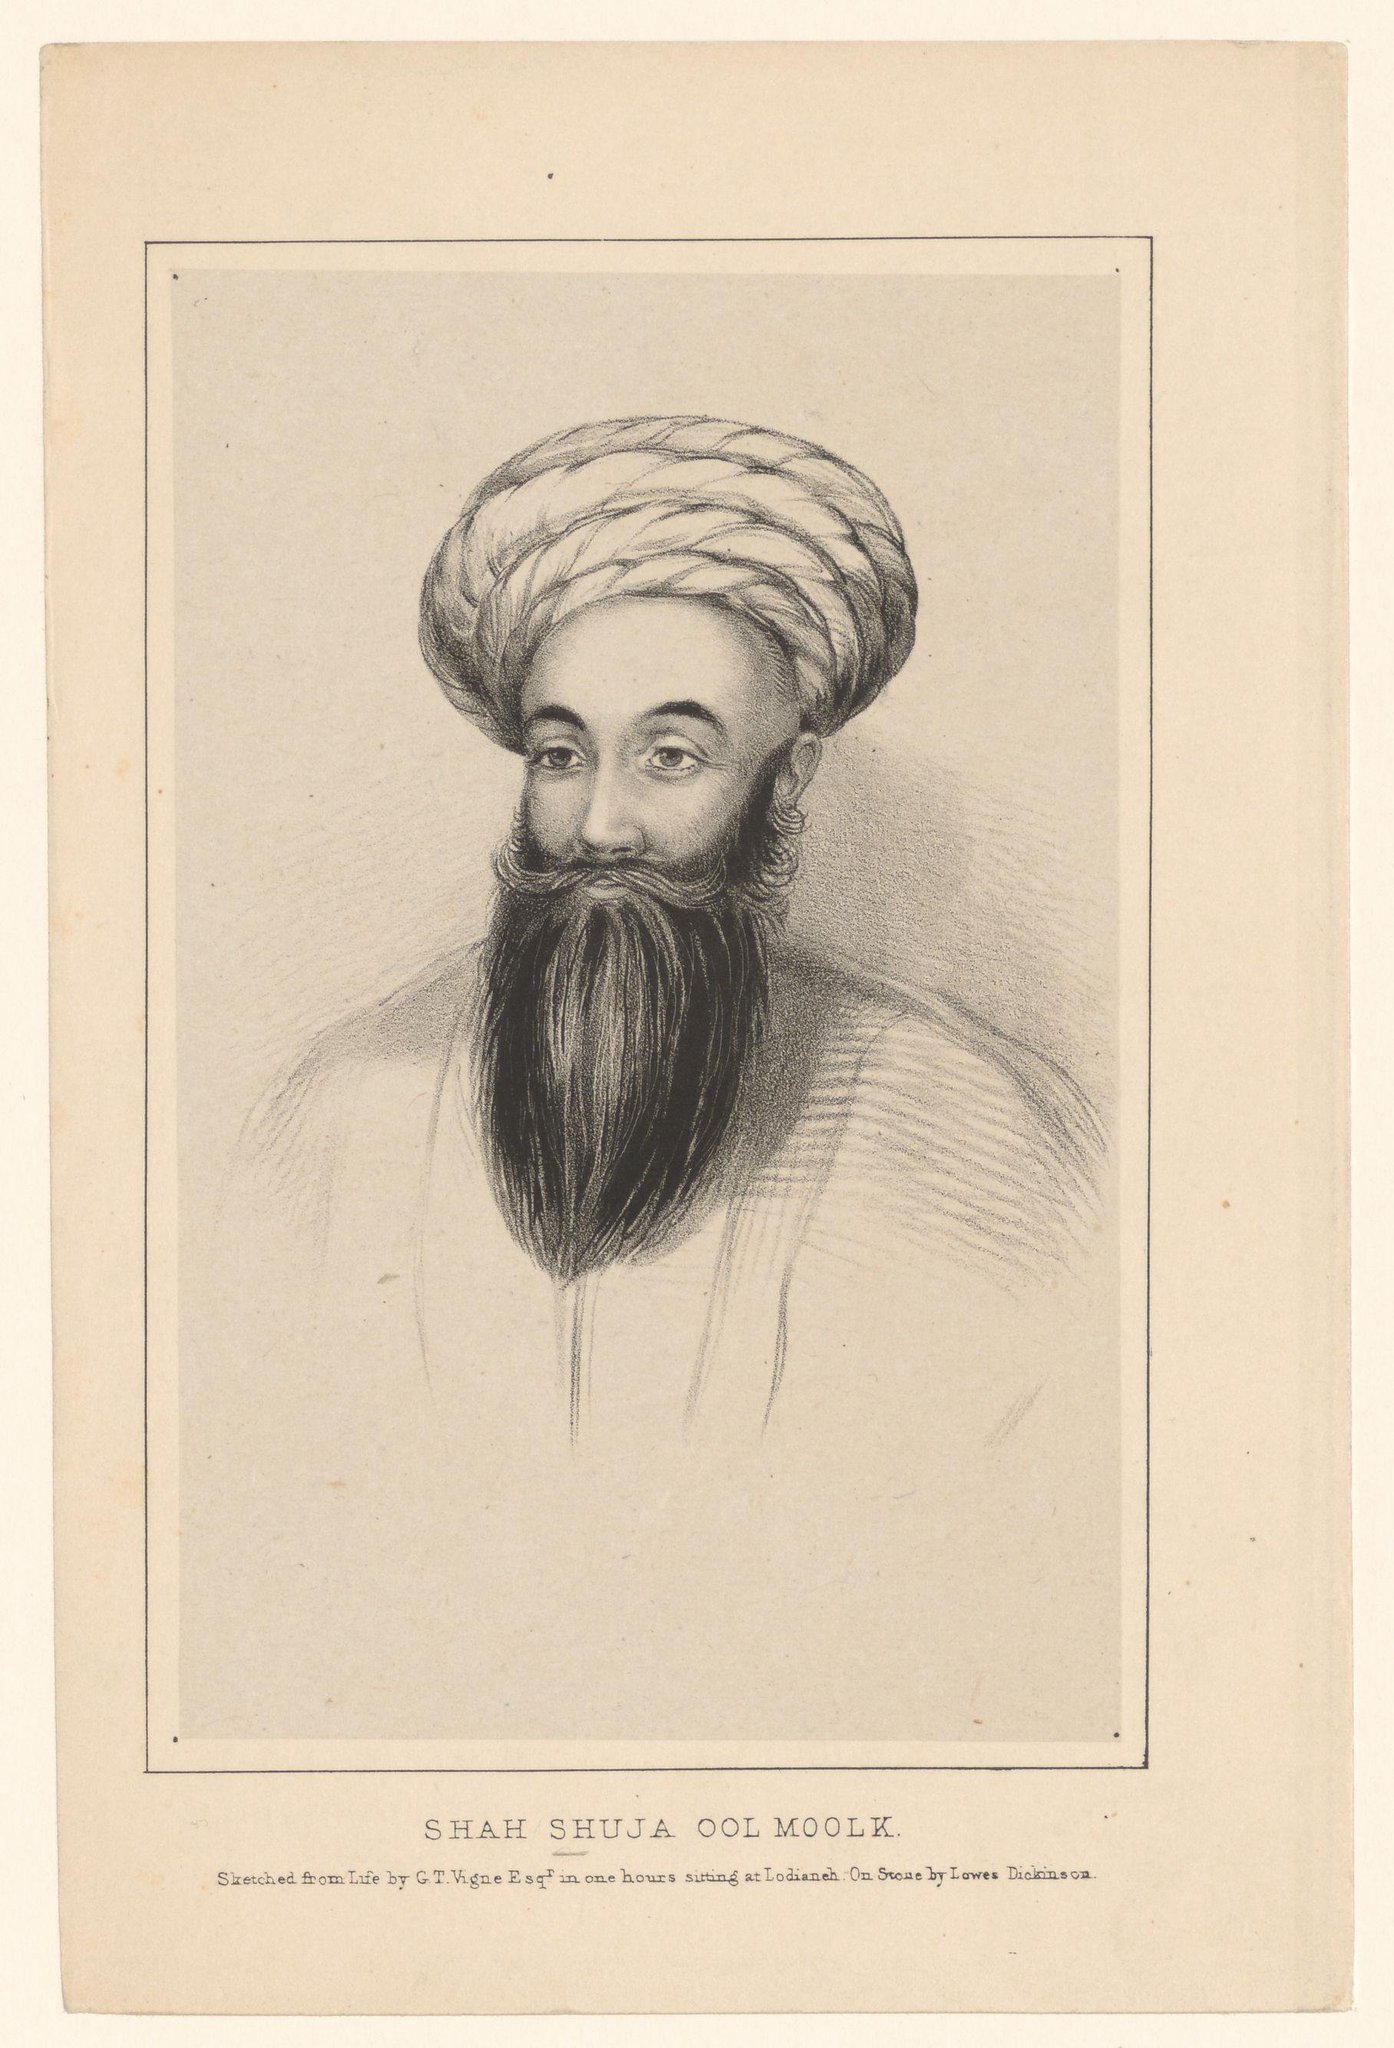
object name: print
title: Portret van Shah Shujah Durrani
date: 1829-1905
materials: paper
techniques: lithograph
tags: adult man, historical persons, head-gear: turban, beard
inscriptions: collector's mark: Lugt 2228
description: Prent behoort mogelijk tot de serie 'Portraits of the Kabul Prisoners'.